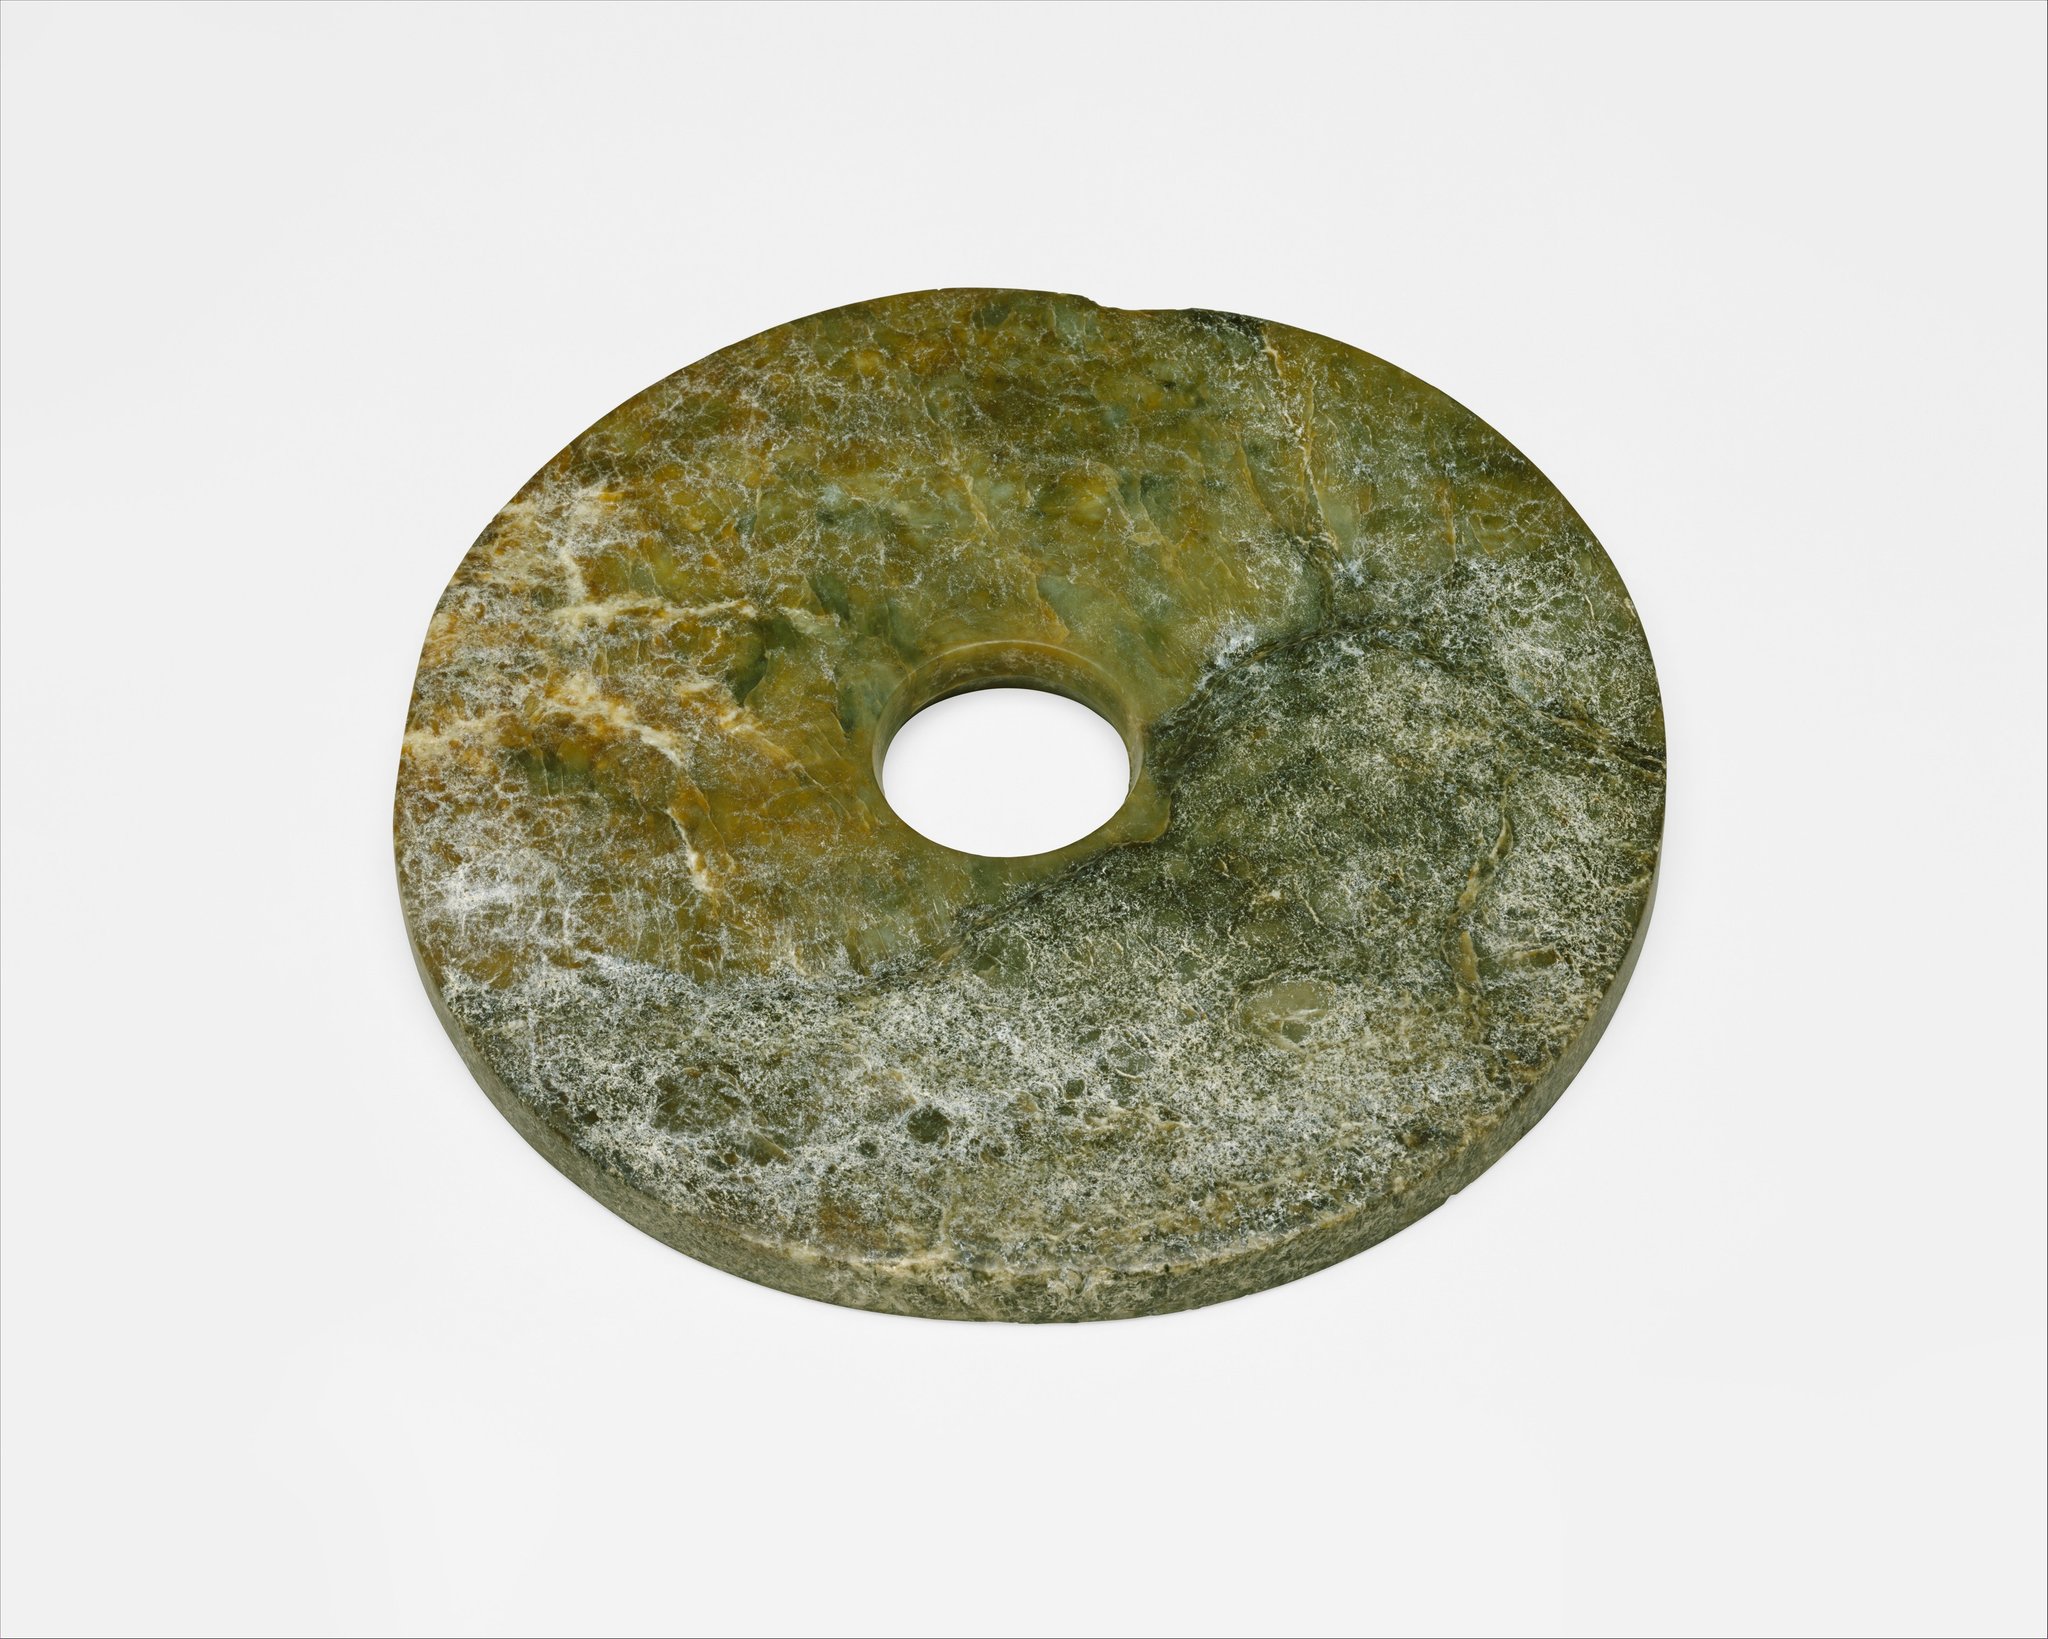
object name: religious ritual object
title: Ritual Object (Bi)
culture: chinese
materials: jade